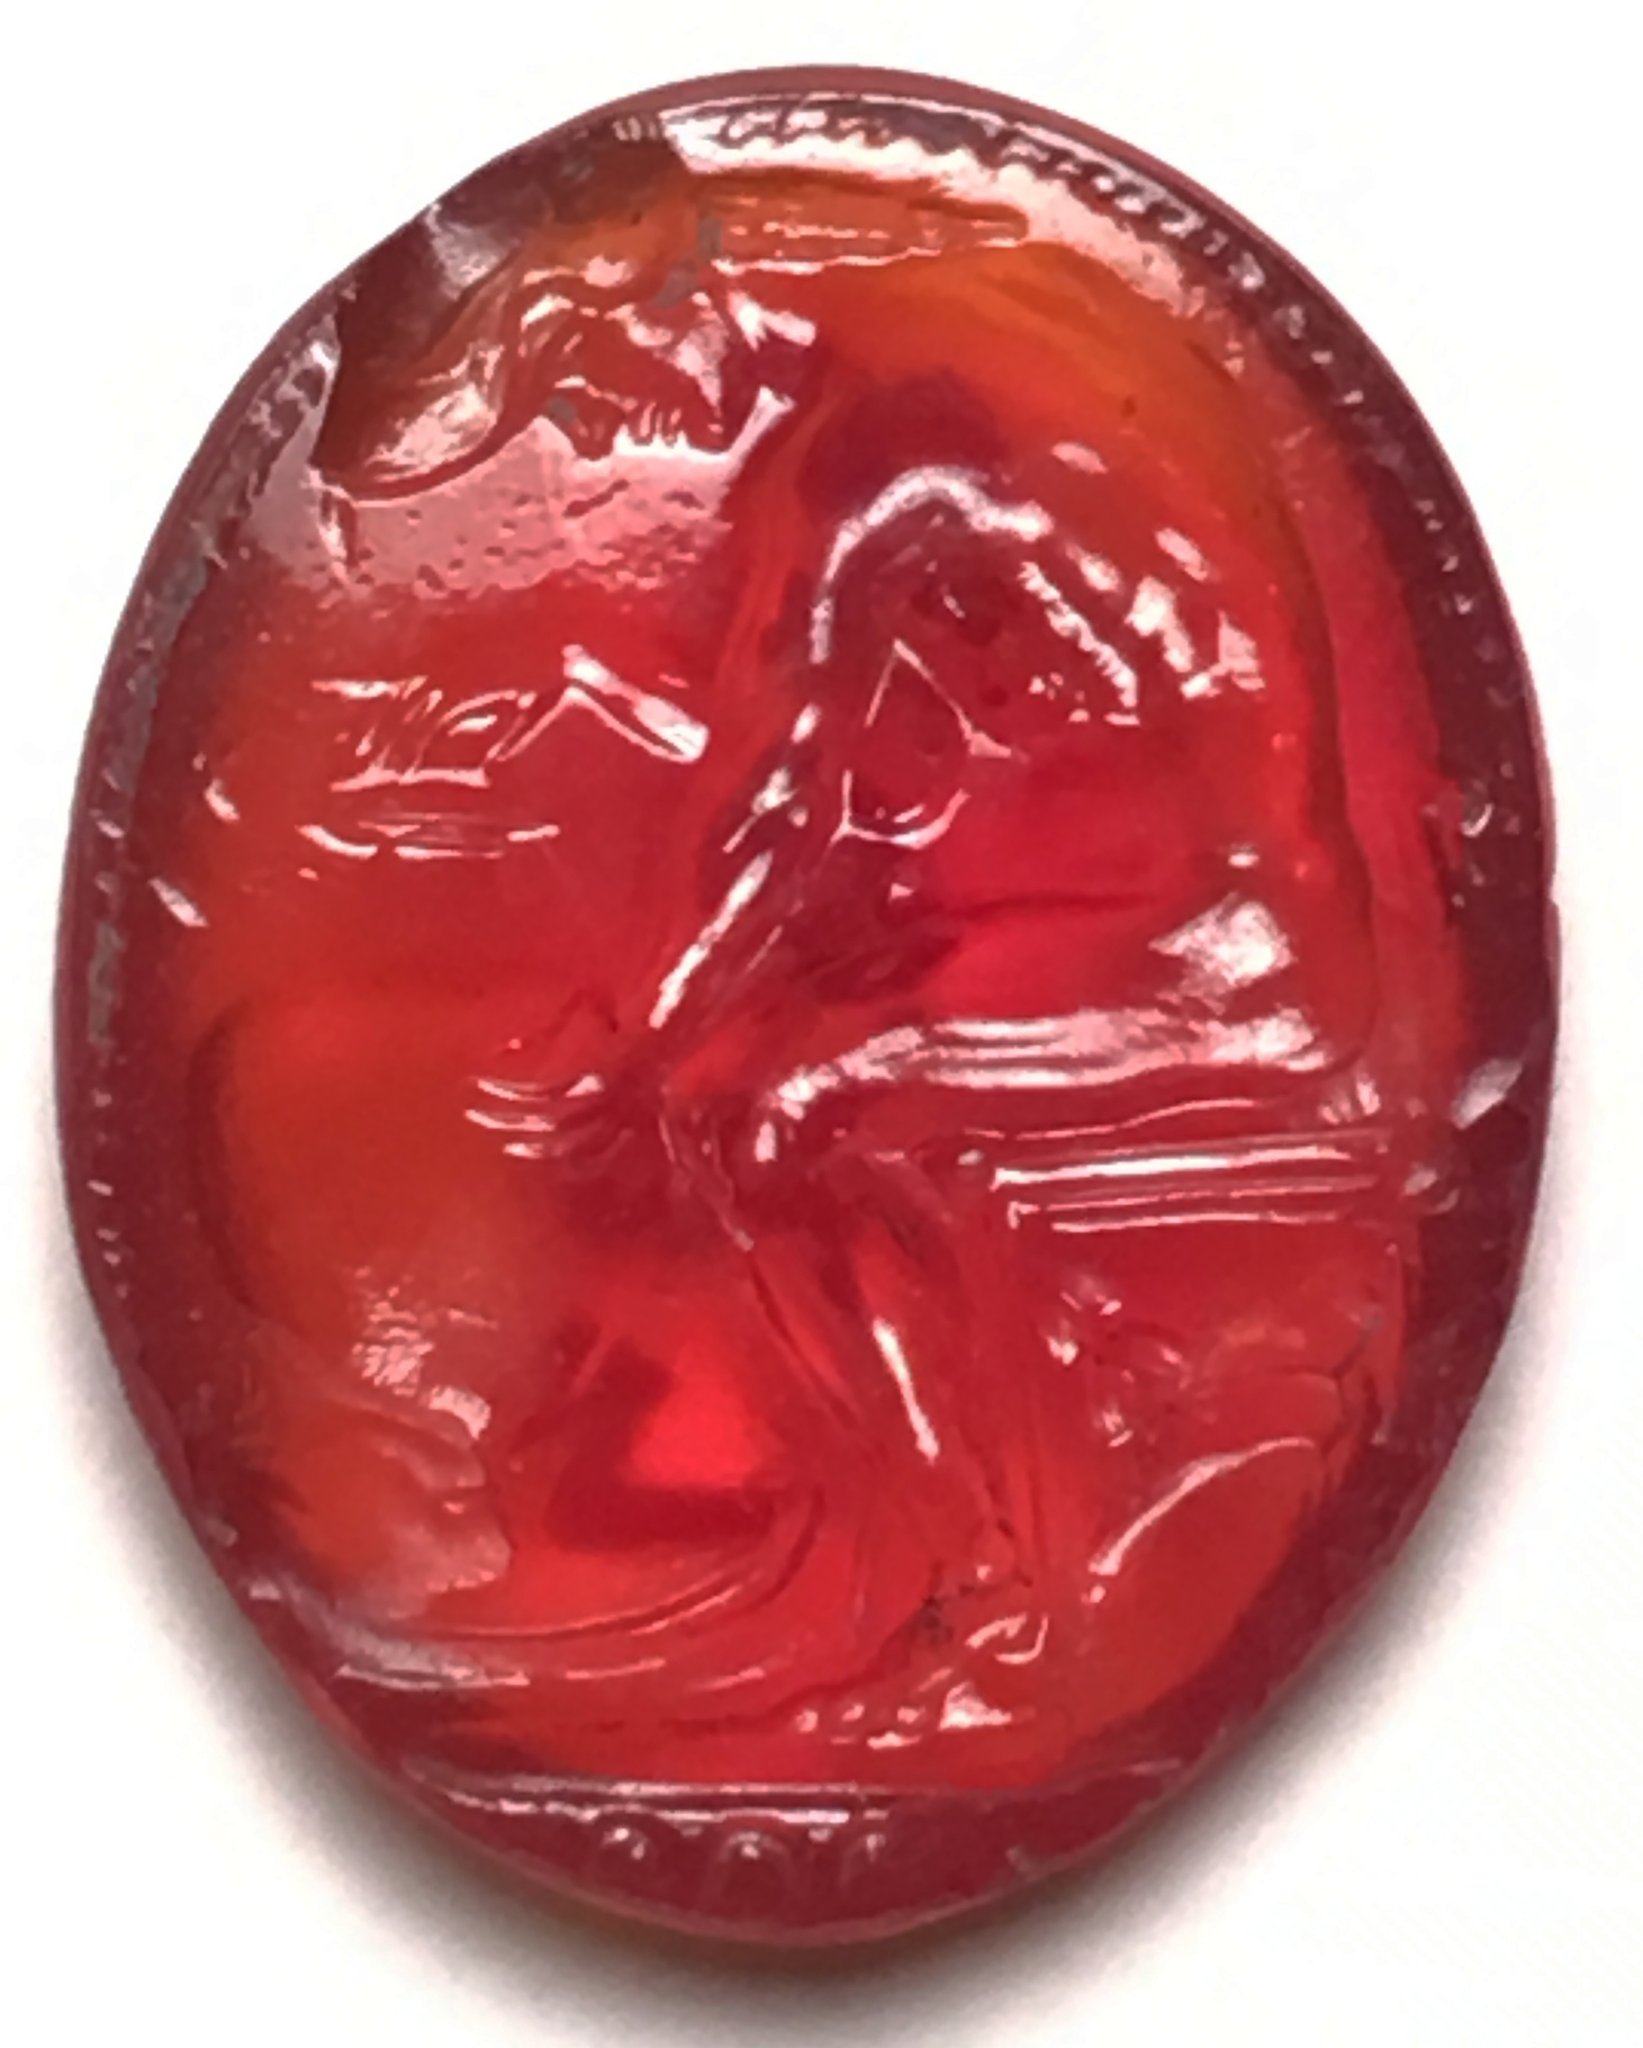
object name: intaglio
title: Sard ring stone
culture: post-classical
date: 7000 BCE-330 CE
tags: men